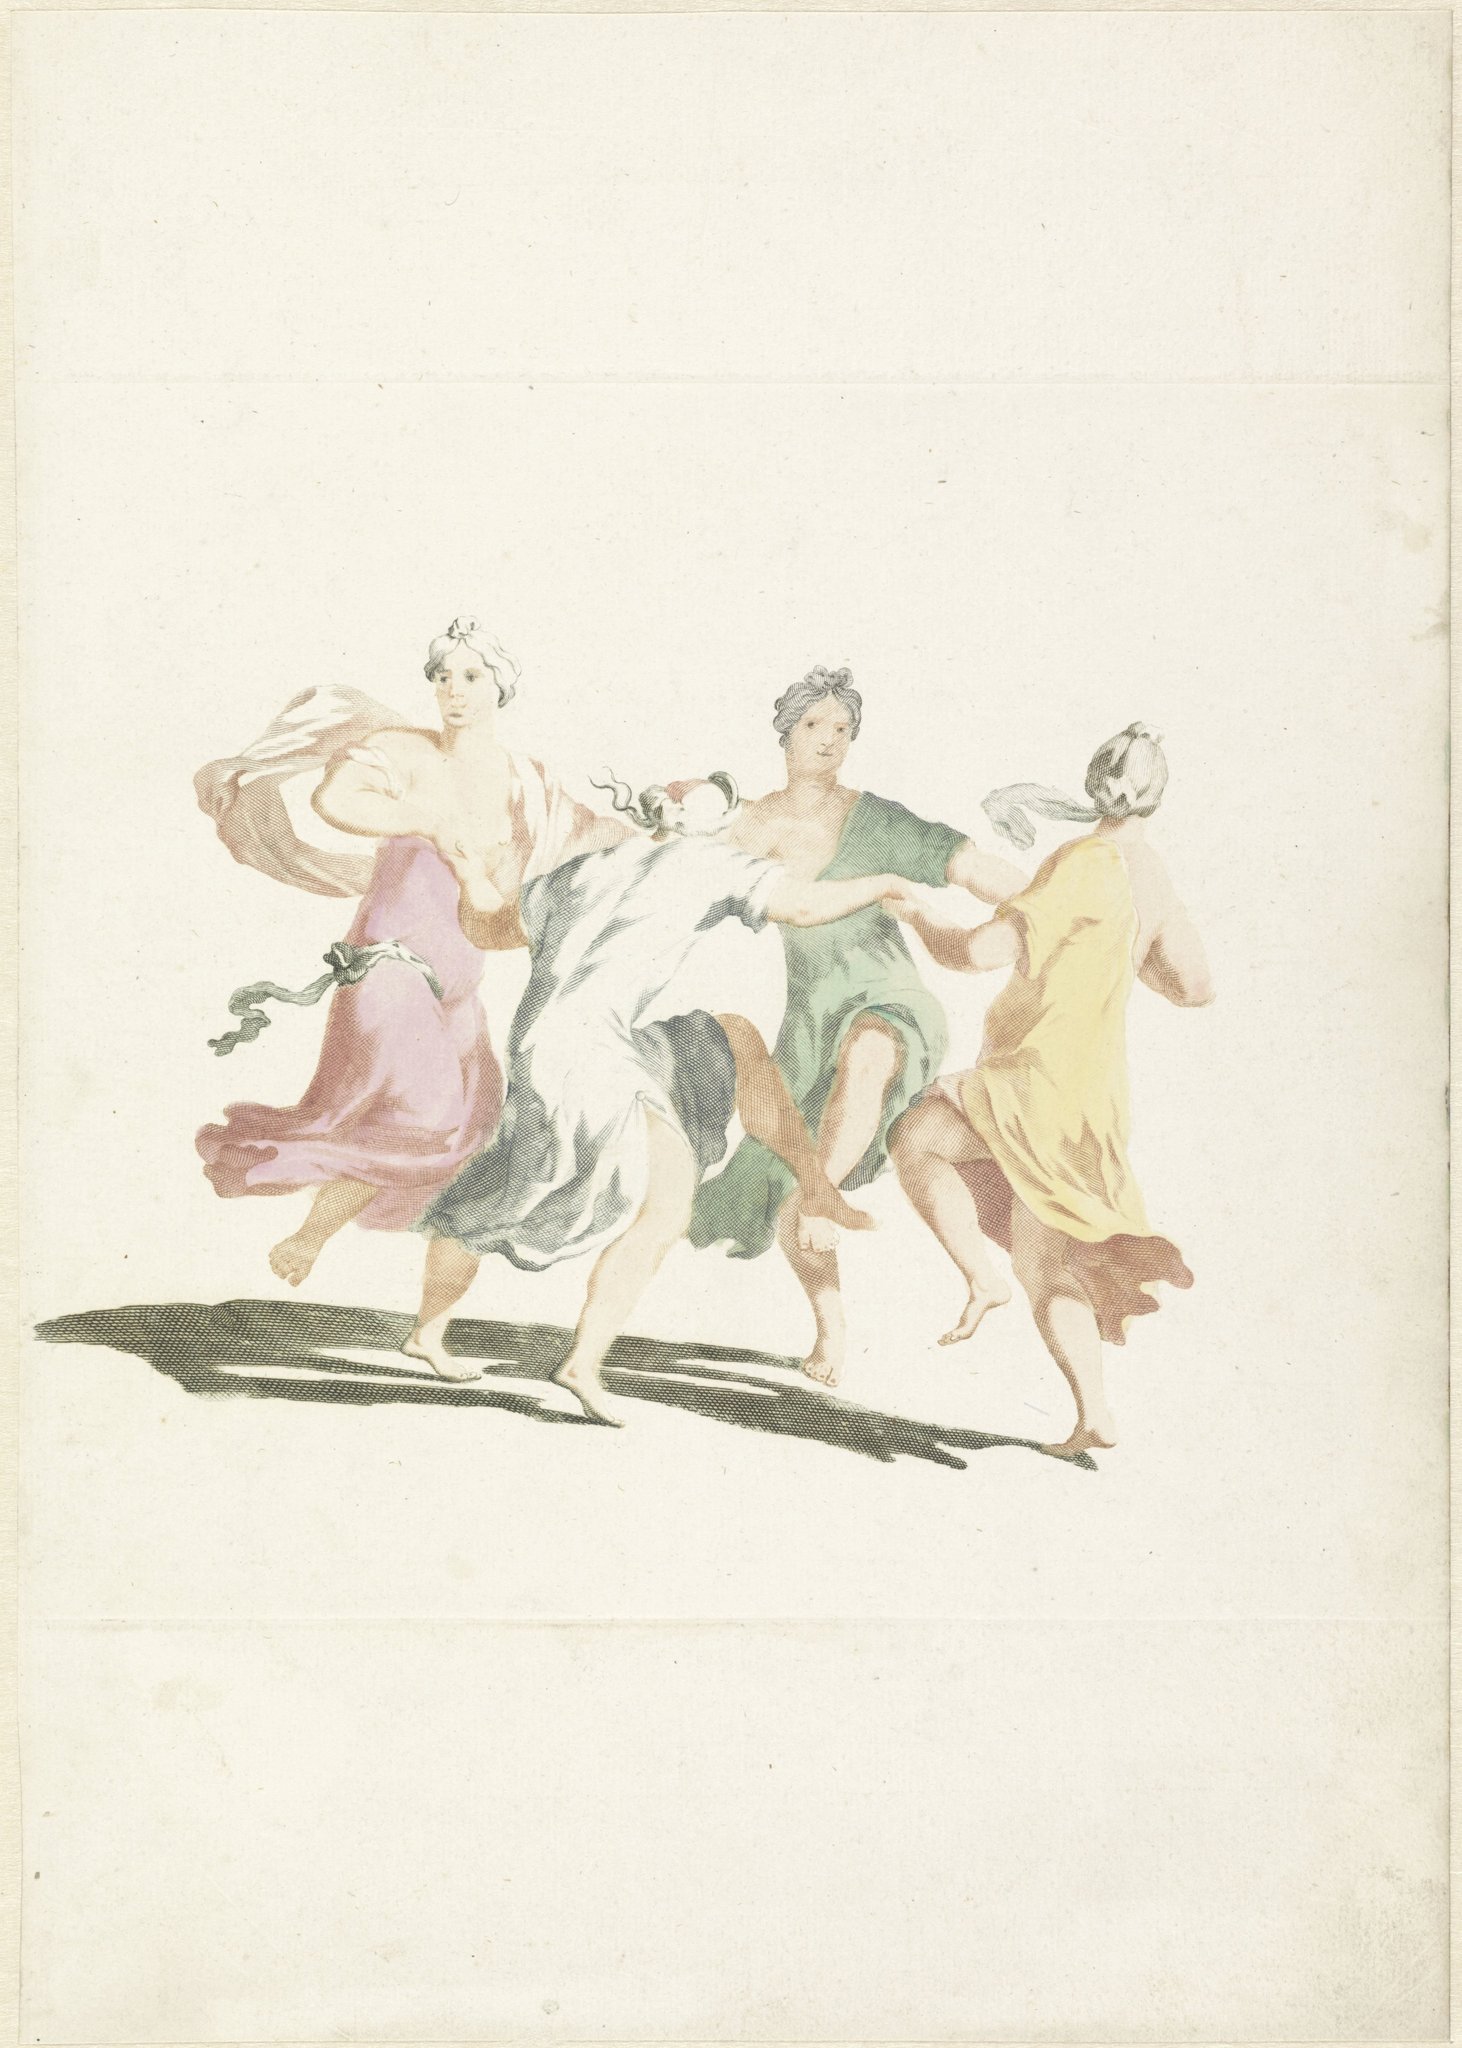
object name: print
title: Vier dansende vrouwen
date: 1688-1698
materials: paper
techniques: engraving, hand coloring, lithography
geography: netherlands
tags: group dancing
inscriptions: collector's mark: Lugt 2760, collector's mark: Lugt 2228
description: Vier vrouwen dansen hand in hand in een kring.